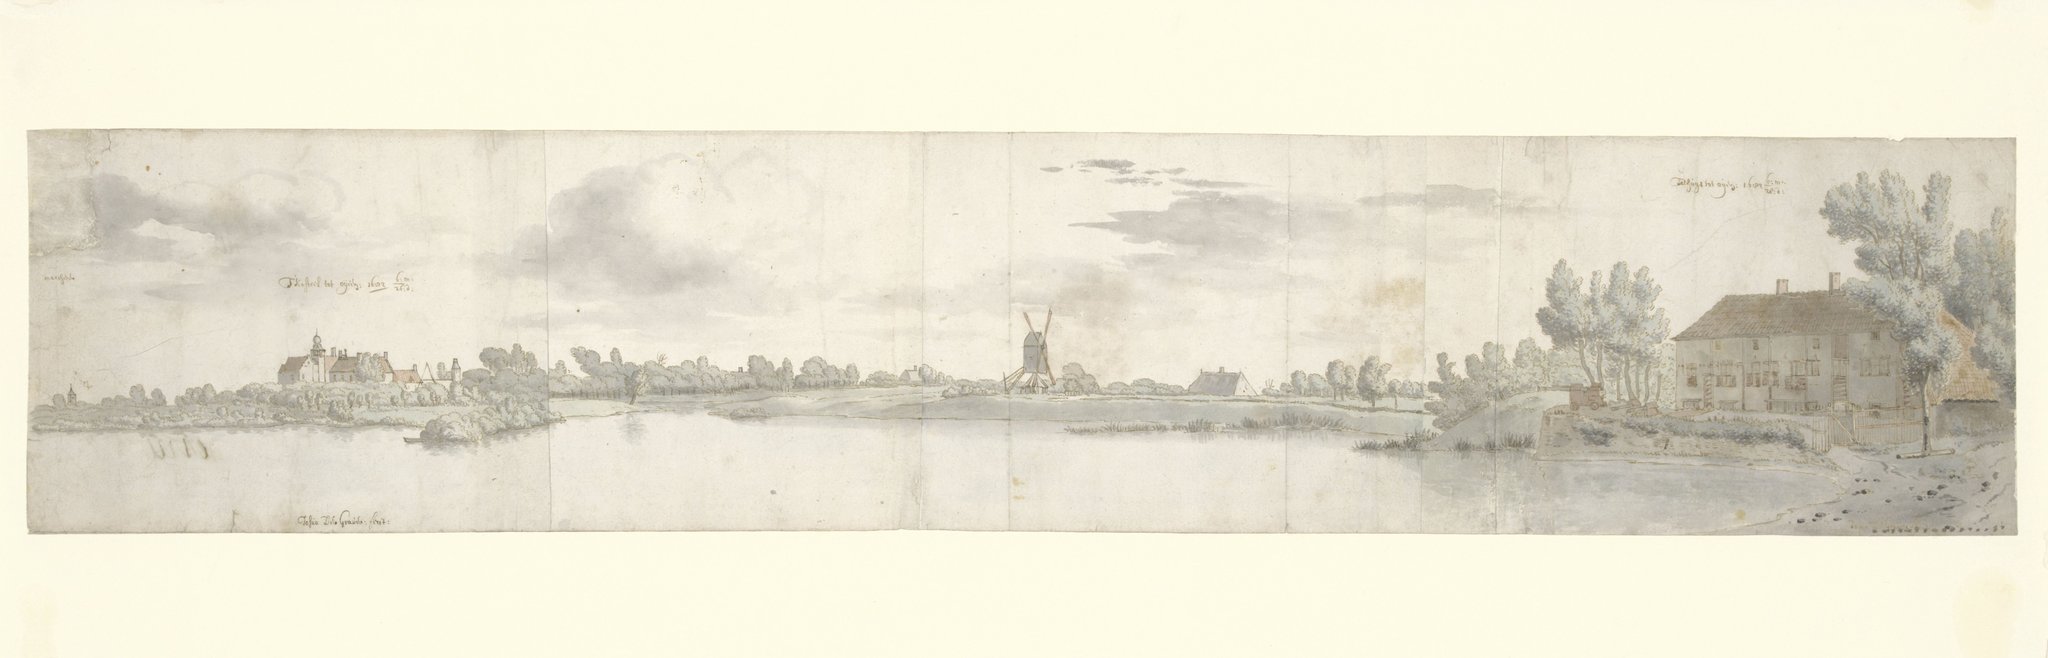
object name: drawing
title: Panoramic View of Kasteel Ooij and the Tollhouse, North Brabant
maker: josua de grave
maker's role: draughtsman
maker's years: 1645-1712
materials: ink, paper, watercolor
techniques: brush, pen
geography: oijen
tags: castle, river, windmill in landscape, toll gate, windmill, farm or solitary house in landscape, oijen